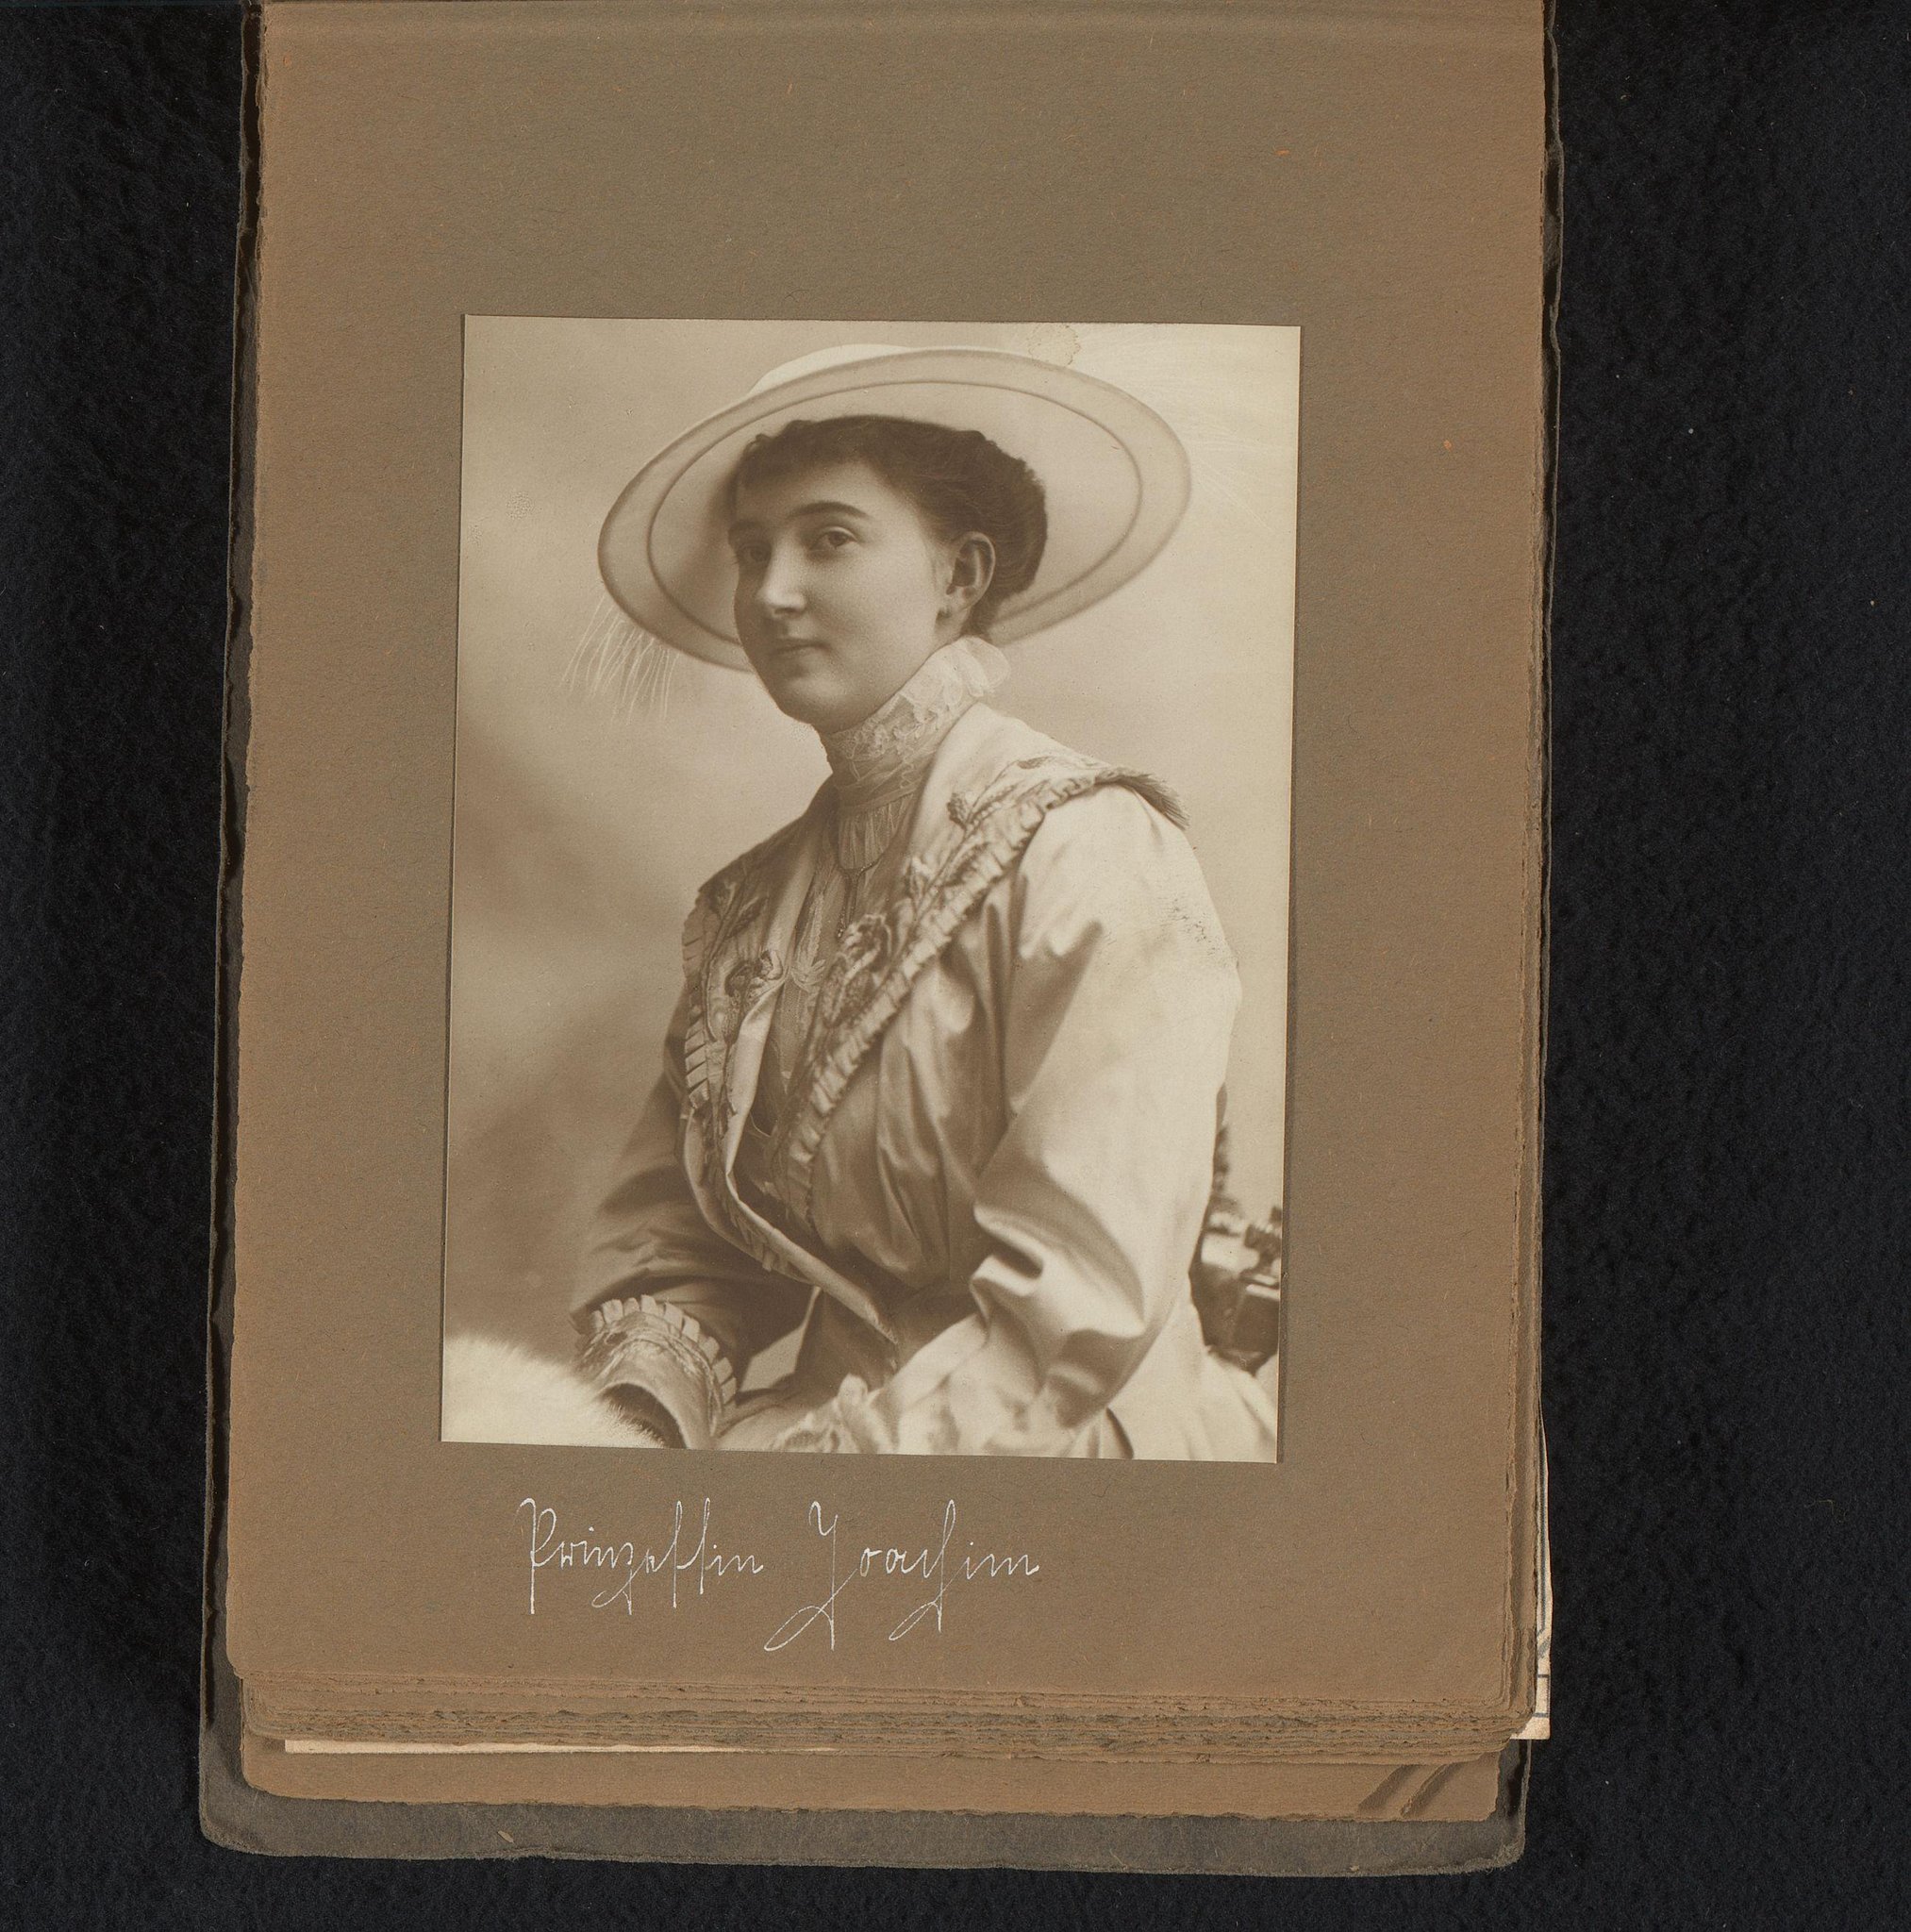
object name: album leaf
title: Prinzessin Joachim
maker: Anonymous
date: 1916-1921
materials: paper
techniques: gelatin silver print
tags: essen, historical persons, princess